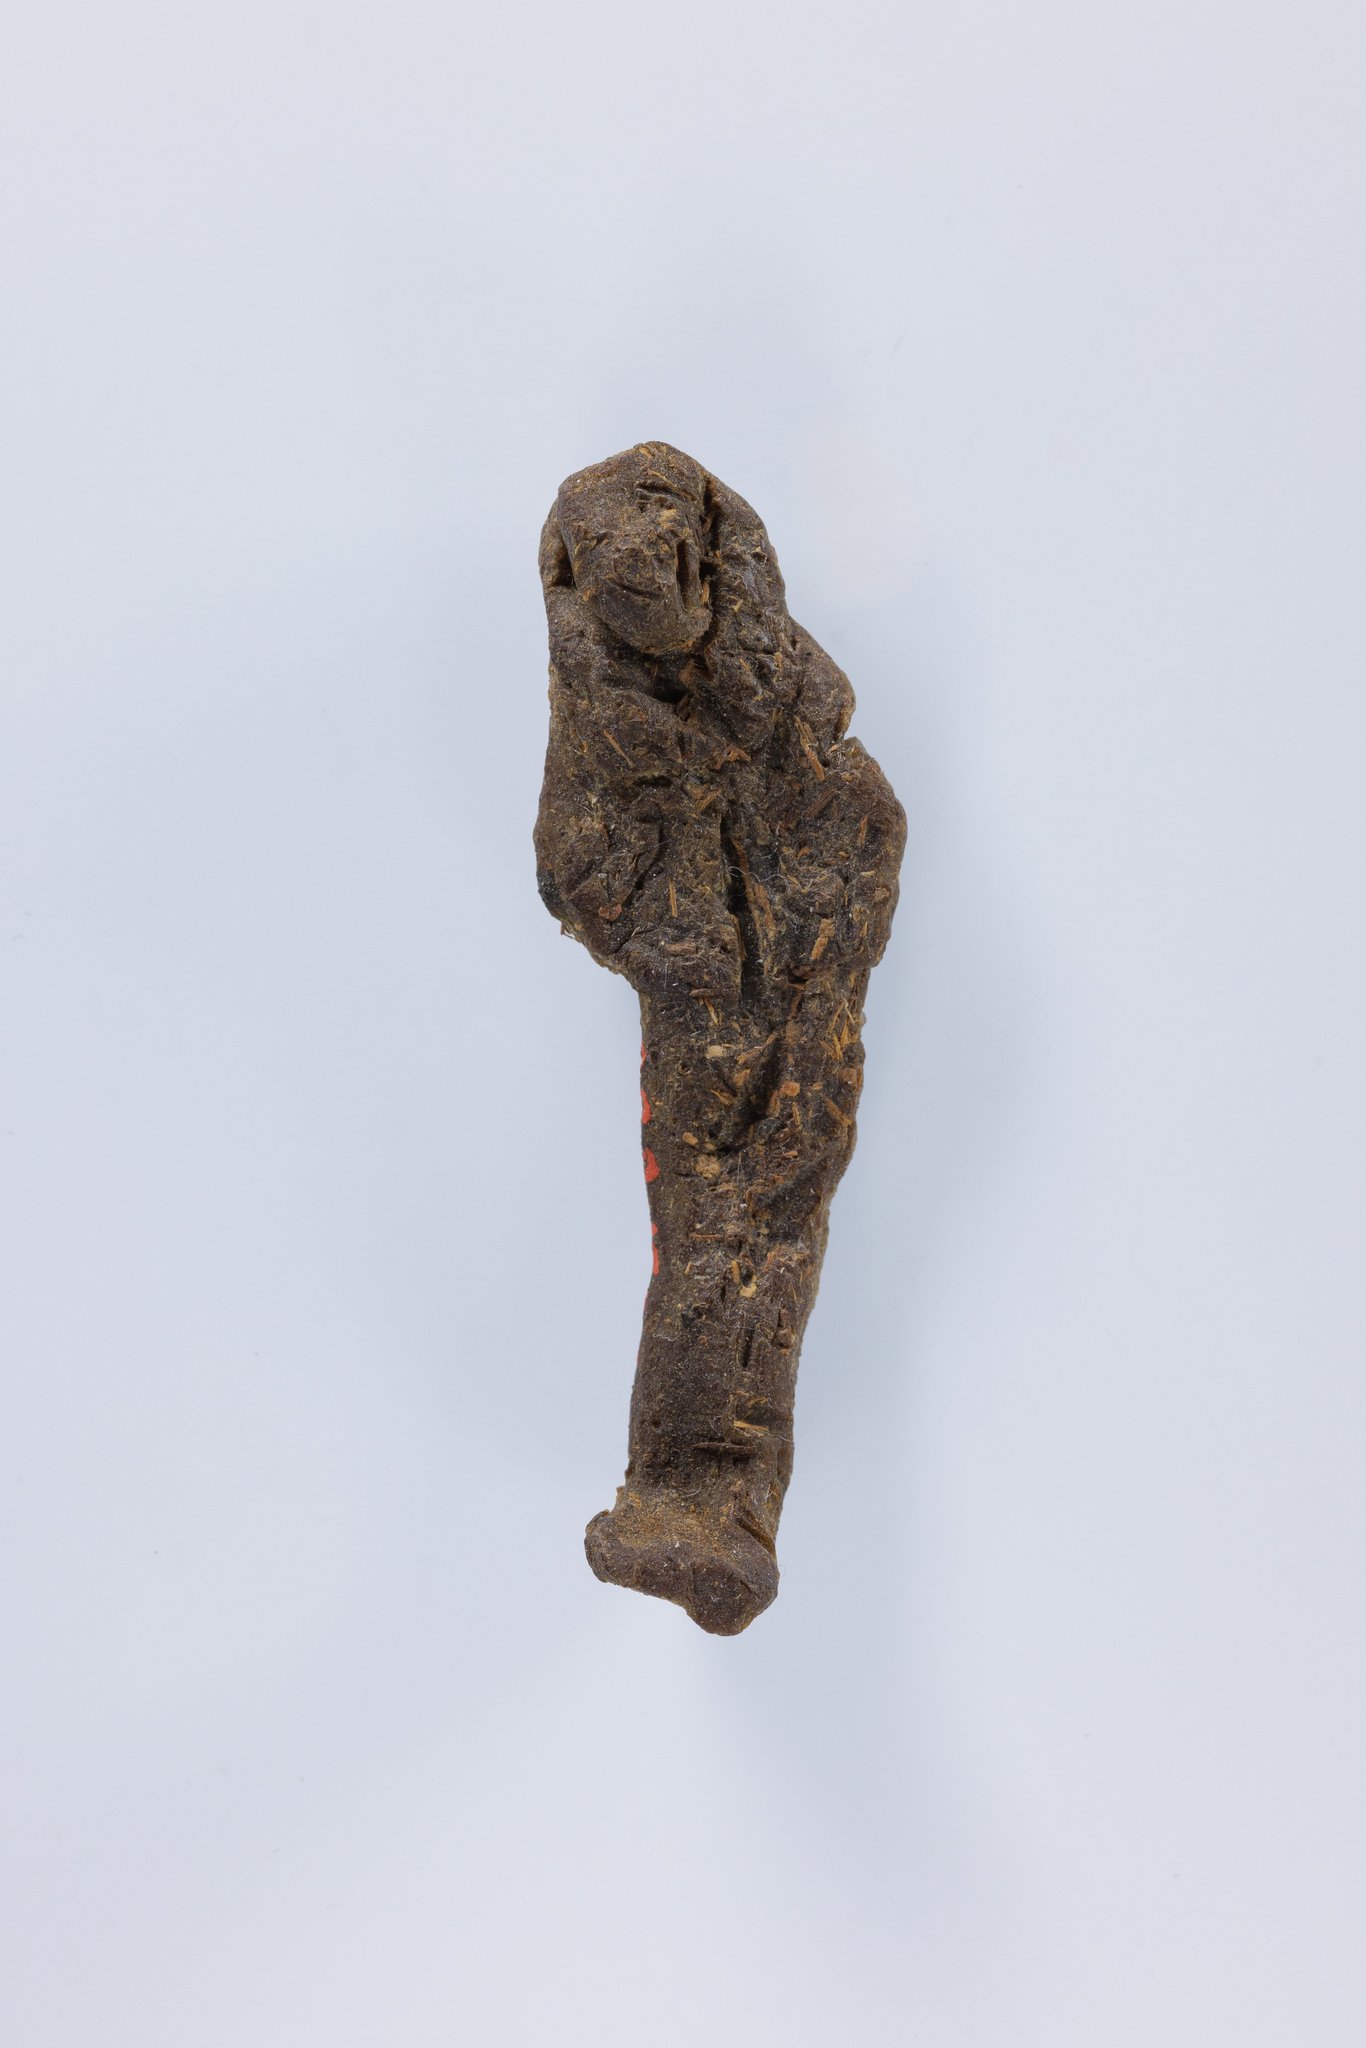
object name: four son of horus, imseti, human head, tiye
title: Viscera figure with human head (Imseti)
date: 1000-945 BCE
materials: wax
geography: egypt